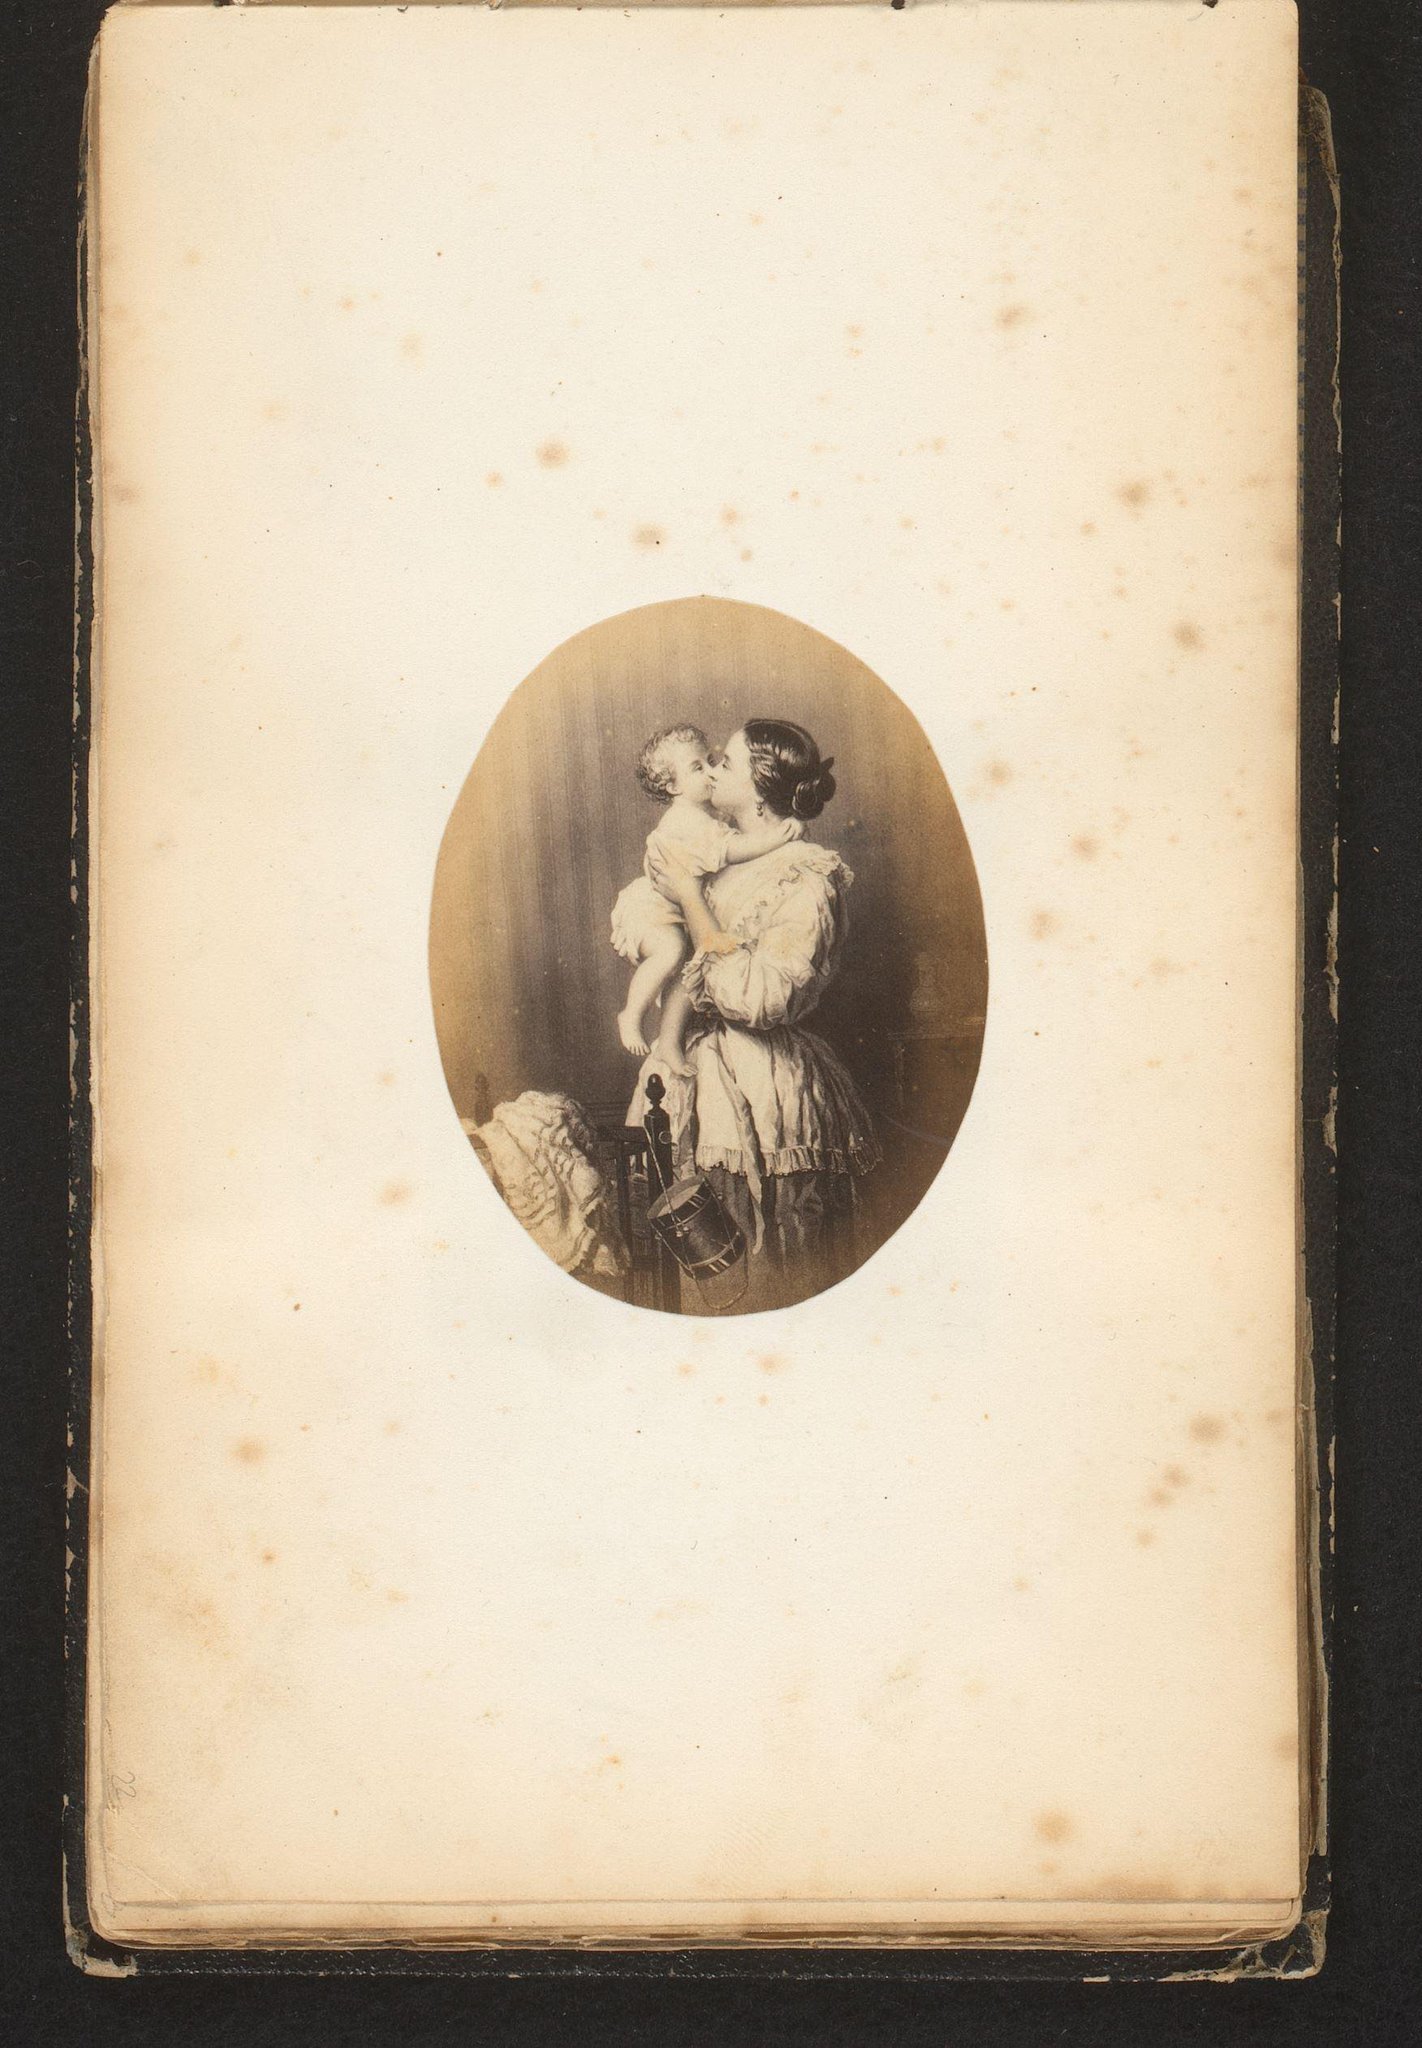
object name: photograph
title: Fotoreproductie van een schilderij van het oogsten met een kar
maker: Anonymous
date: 1860-1900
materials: photographic support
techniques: albumen print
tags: harvest, bovine cattle, painting, drawing and the graphic arts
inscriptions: annotation: ‘une moissonneuse italienne’